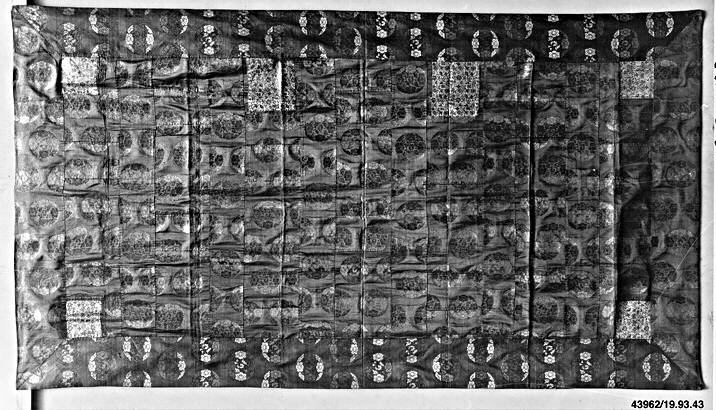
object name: robe, priest's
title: Priest's Robe (Shichijō)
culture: japanese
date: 1596-1615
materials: metal thread, silk